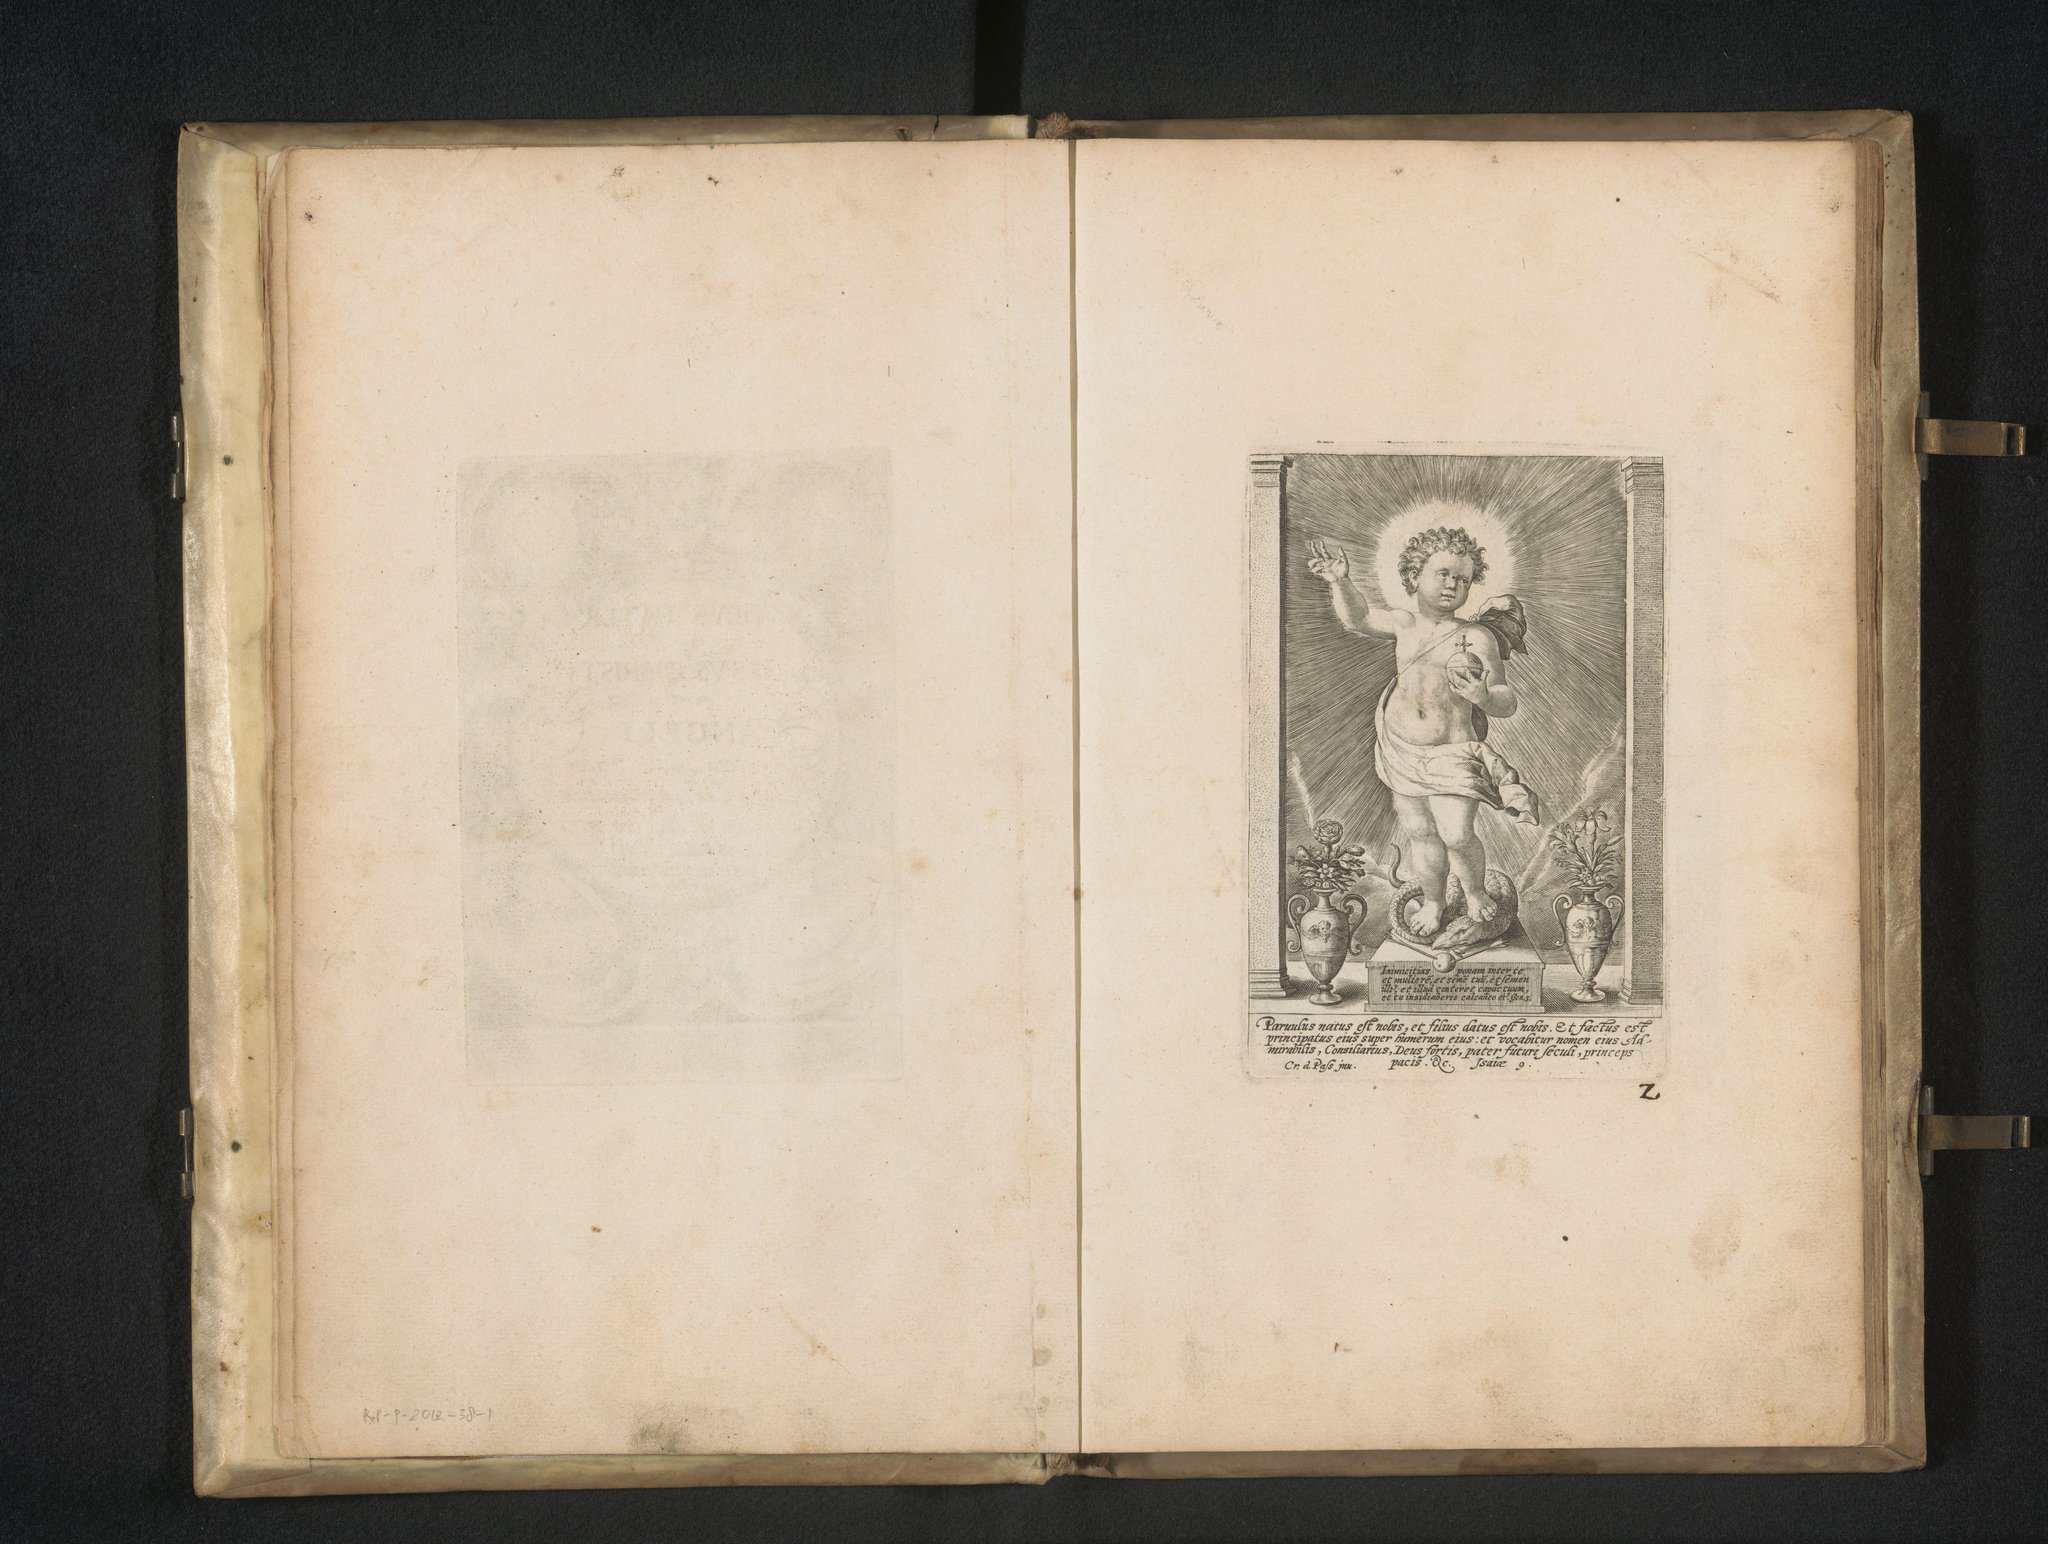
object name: print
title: Christuskind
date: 1585-1637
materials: paper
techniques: engraving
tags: 'salvator mundi', making a blessing gesture; an orb in his hand or at his feet, christ-child ~ types of adult christ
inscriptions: number: ‘2’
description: Christuskind in stralenkrans tussen pilasters met rijksappel in de hand staande op een slang. Maakt in dit album deel uit van een serie van twaalf voorstellingen van aartsengelen en andere engelen, maar behoort waarschijnlijk niet tot de oorspronkelijke serie. Onderdeel van een album met voornamelijk christelijke voorstellingen.